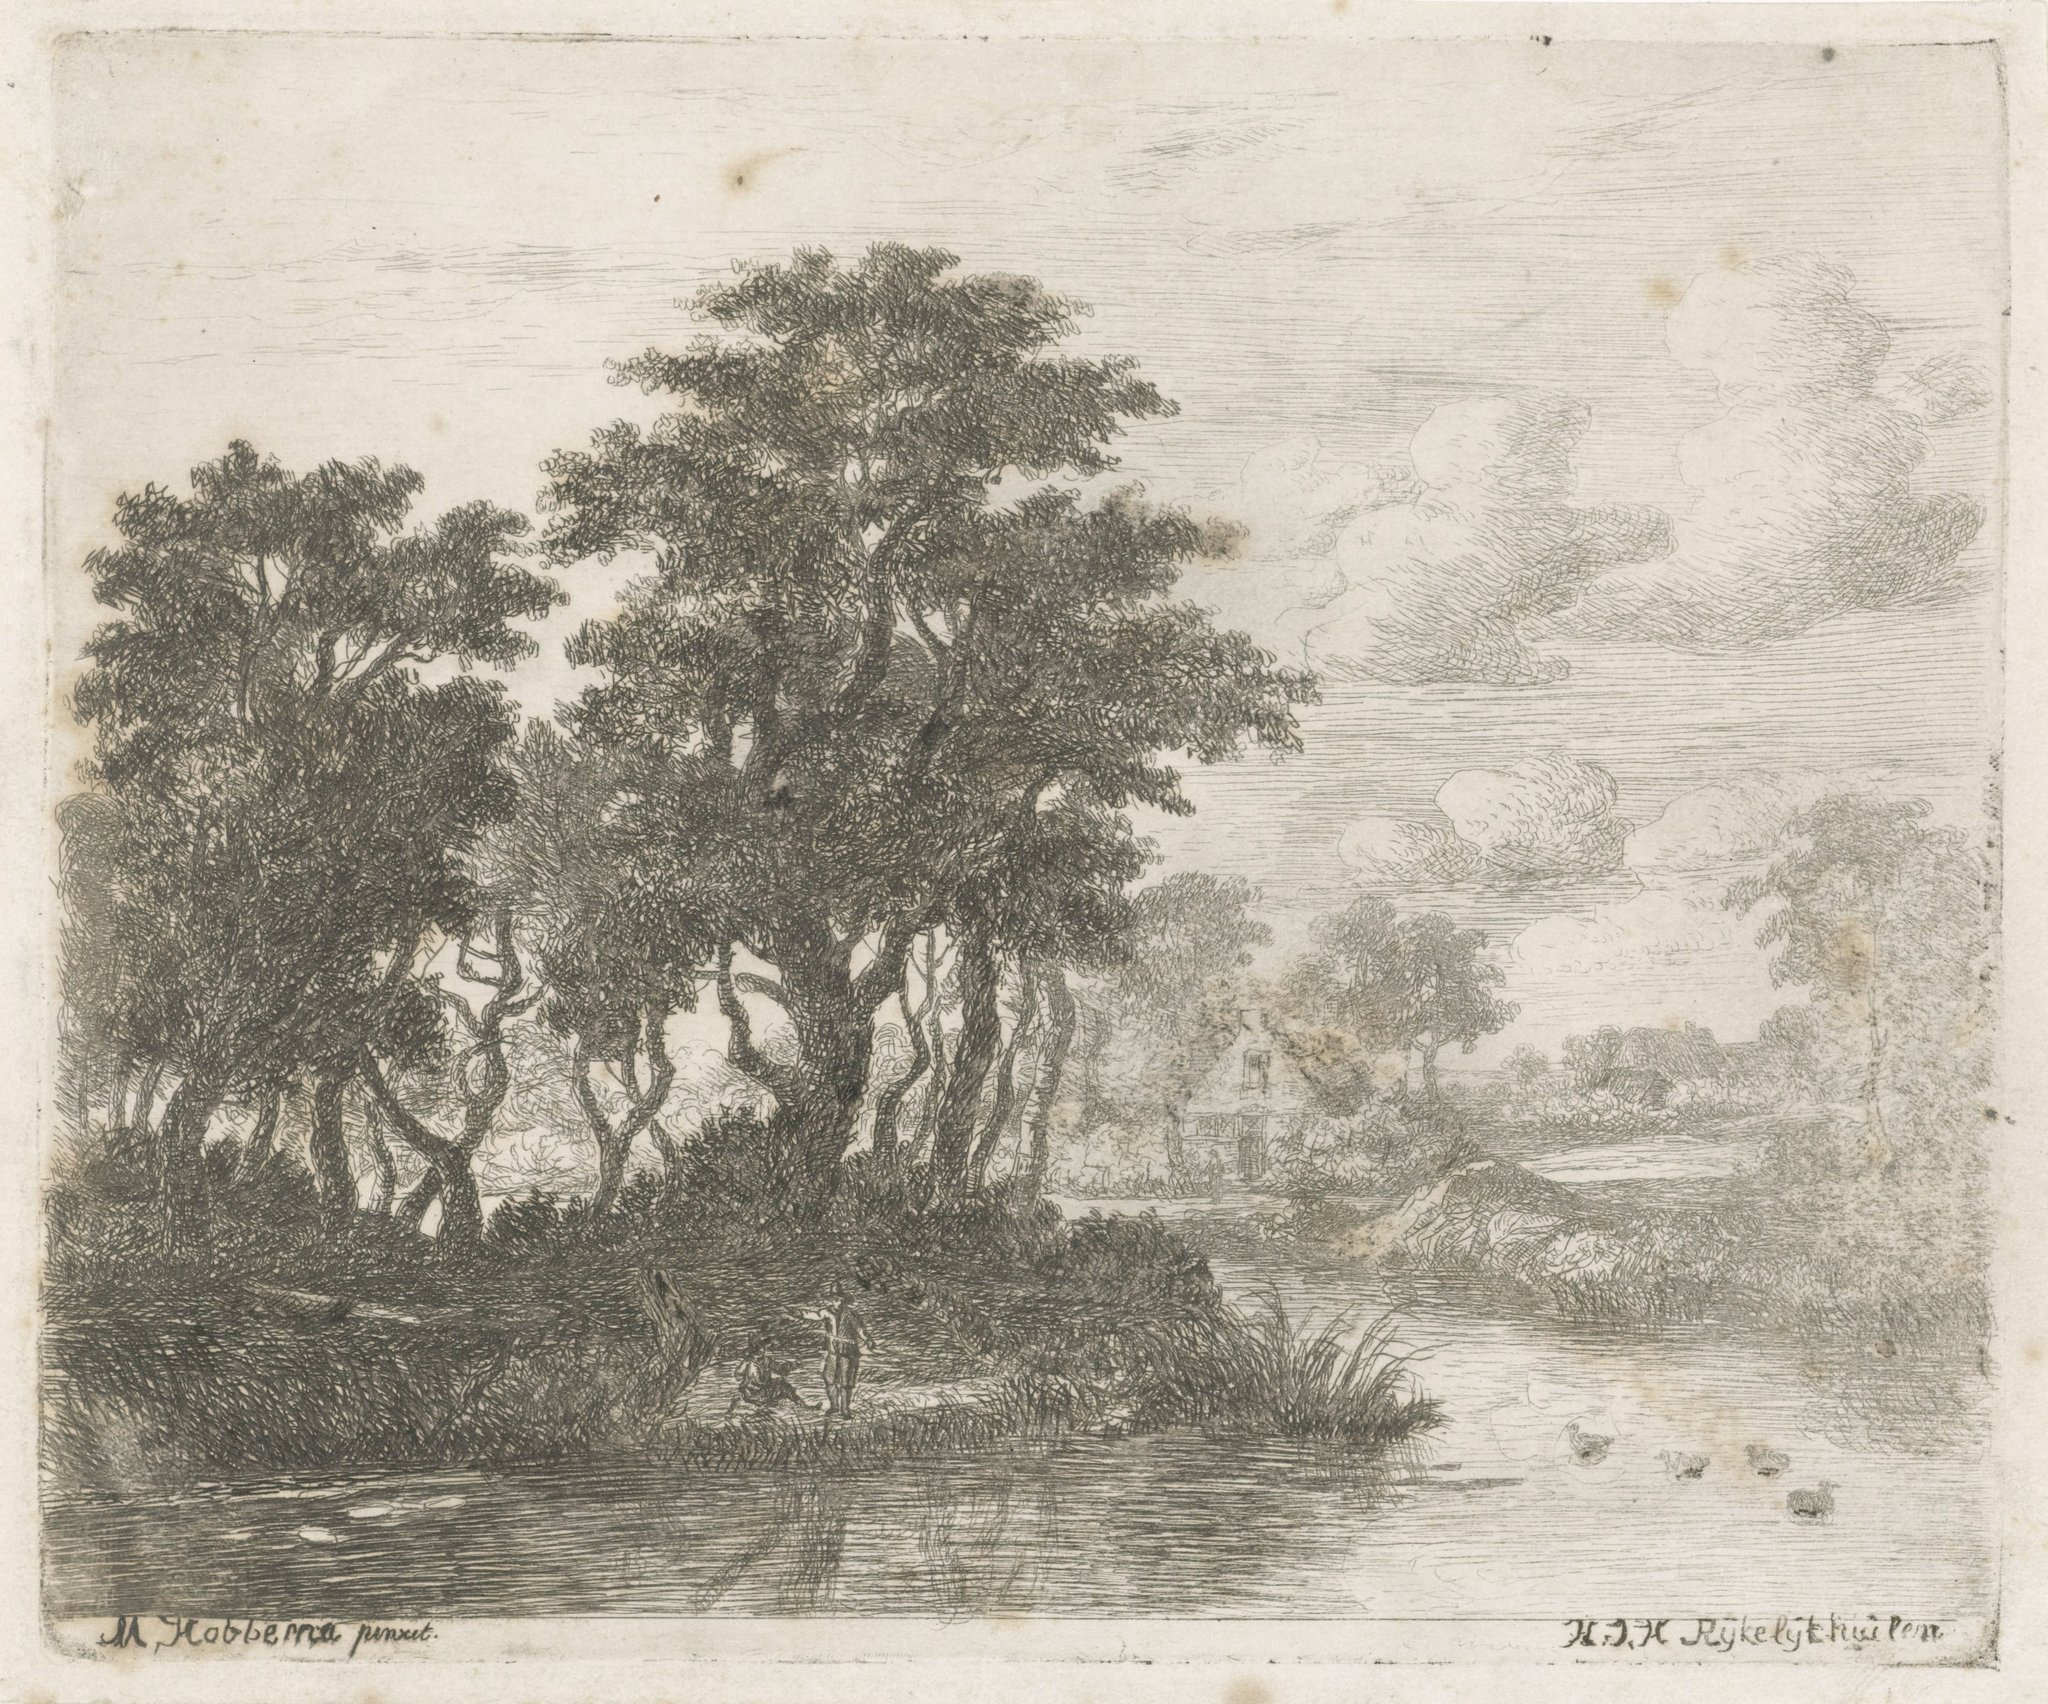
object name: print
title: Rivierlandschap met een hengelaar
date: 1823-1883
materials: paper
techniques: drypoint, etching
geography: utrecht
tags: trees, river, road, path, water-birds: duck, fisherman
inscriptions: collector's mark: Lugt 1485, collector's mark: Lugt 2228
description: Een rivier met links een stuk land met hoge bomen, waar zich twee mannen aan de oever van het water bevinden. Een van hen heeft zijn hengel uitgegooid. Rechts aan de overkant loopt een landweg waaraan enige huizen liggen. Op de voorgrond vier eenden.